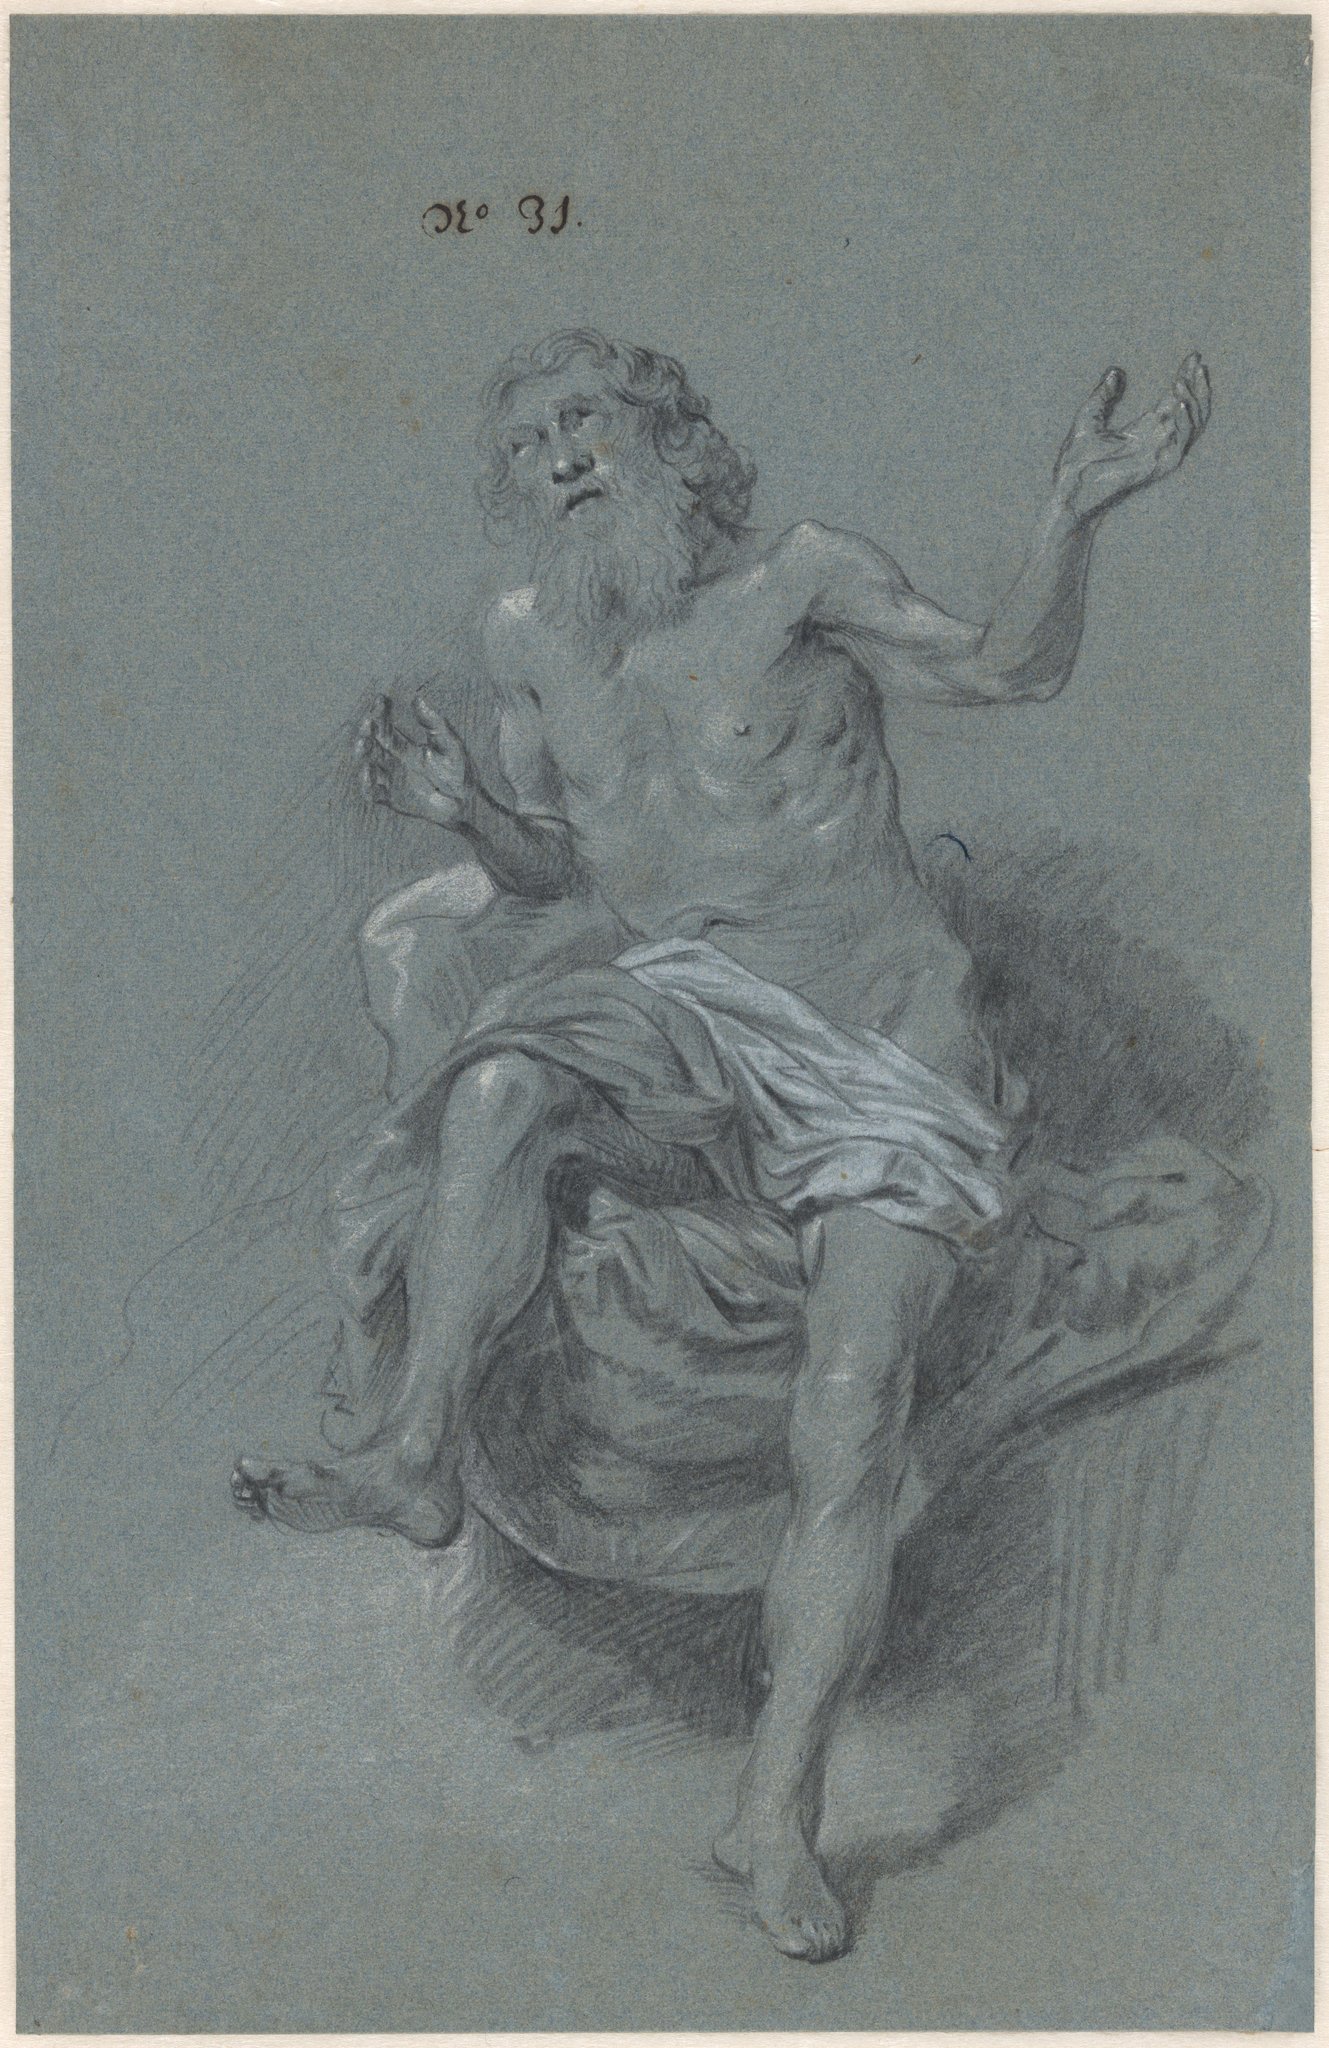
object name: drawing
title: Seated old man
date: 1630-1670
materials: chalk, paper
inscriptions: number: ‘N°31’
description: De groep (RP-T-2015-53-1 t/m 7) omvat vijf tekeningen en twee tegendrukken. Ze komen uit een album waarin ook dertien tekeningen van Jacques de Gheyn werden bewaard, die verspreid zijn geraakt. De bladen uit dit album zijn herkenbaar aan een vermoedelijk in de zeventiende eeuw aangebrachte nummering. Zie Boon 1992, pp. 153-157, no. 84.